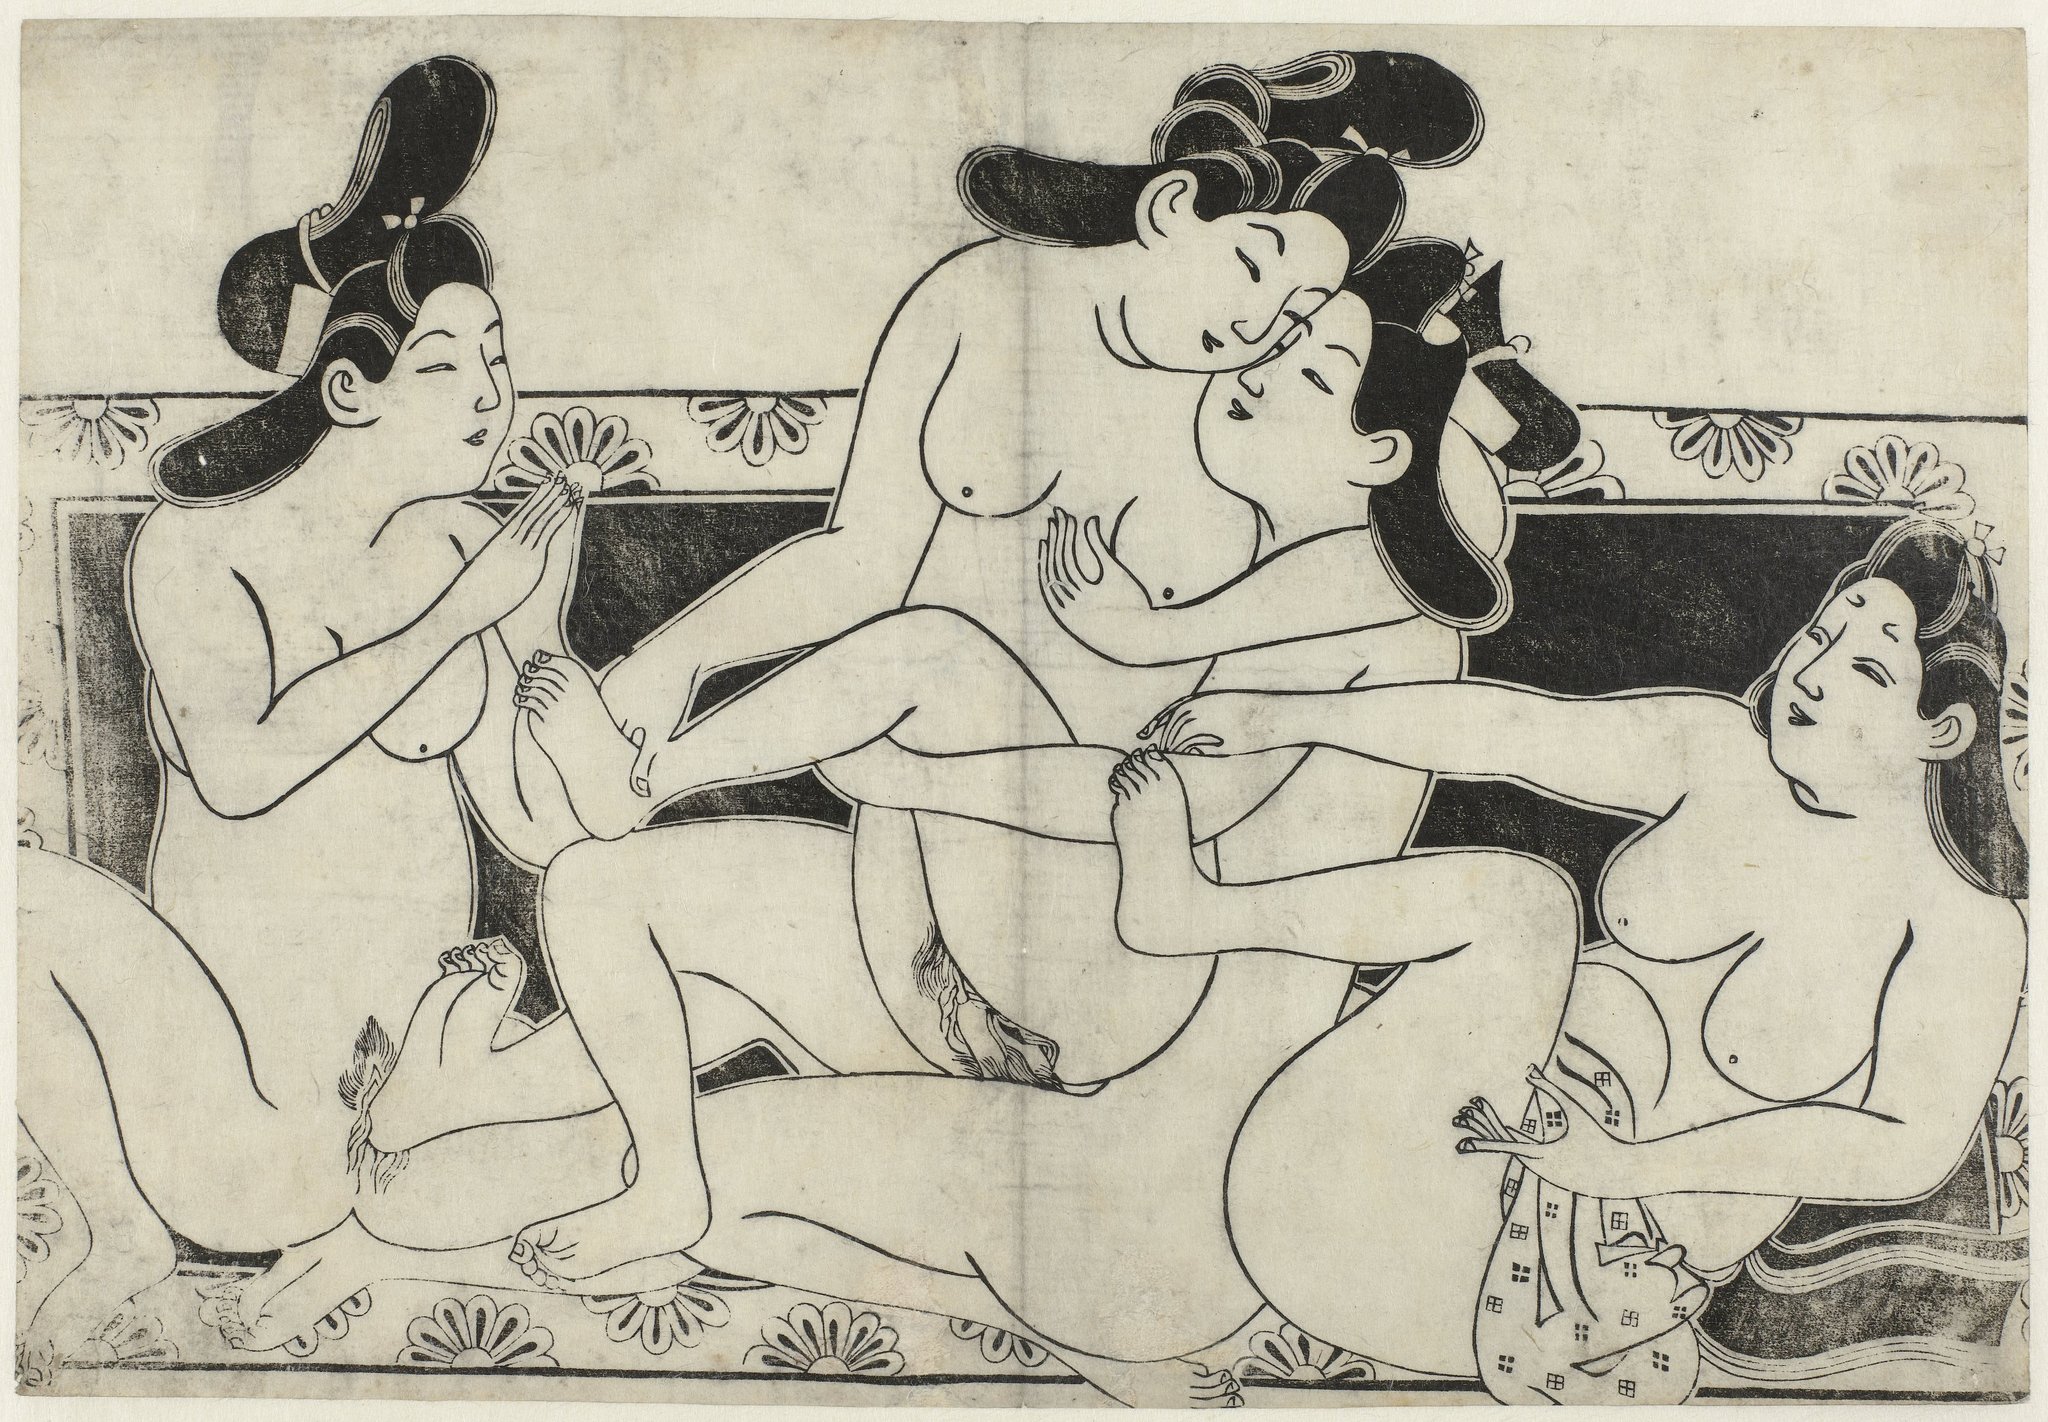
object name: print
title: Erotische voorstelling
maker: sugimura jihei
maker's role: print maker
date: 1680-1698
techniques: woodcut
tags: group-sex